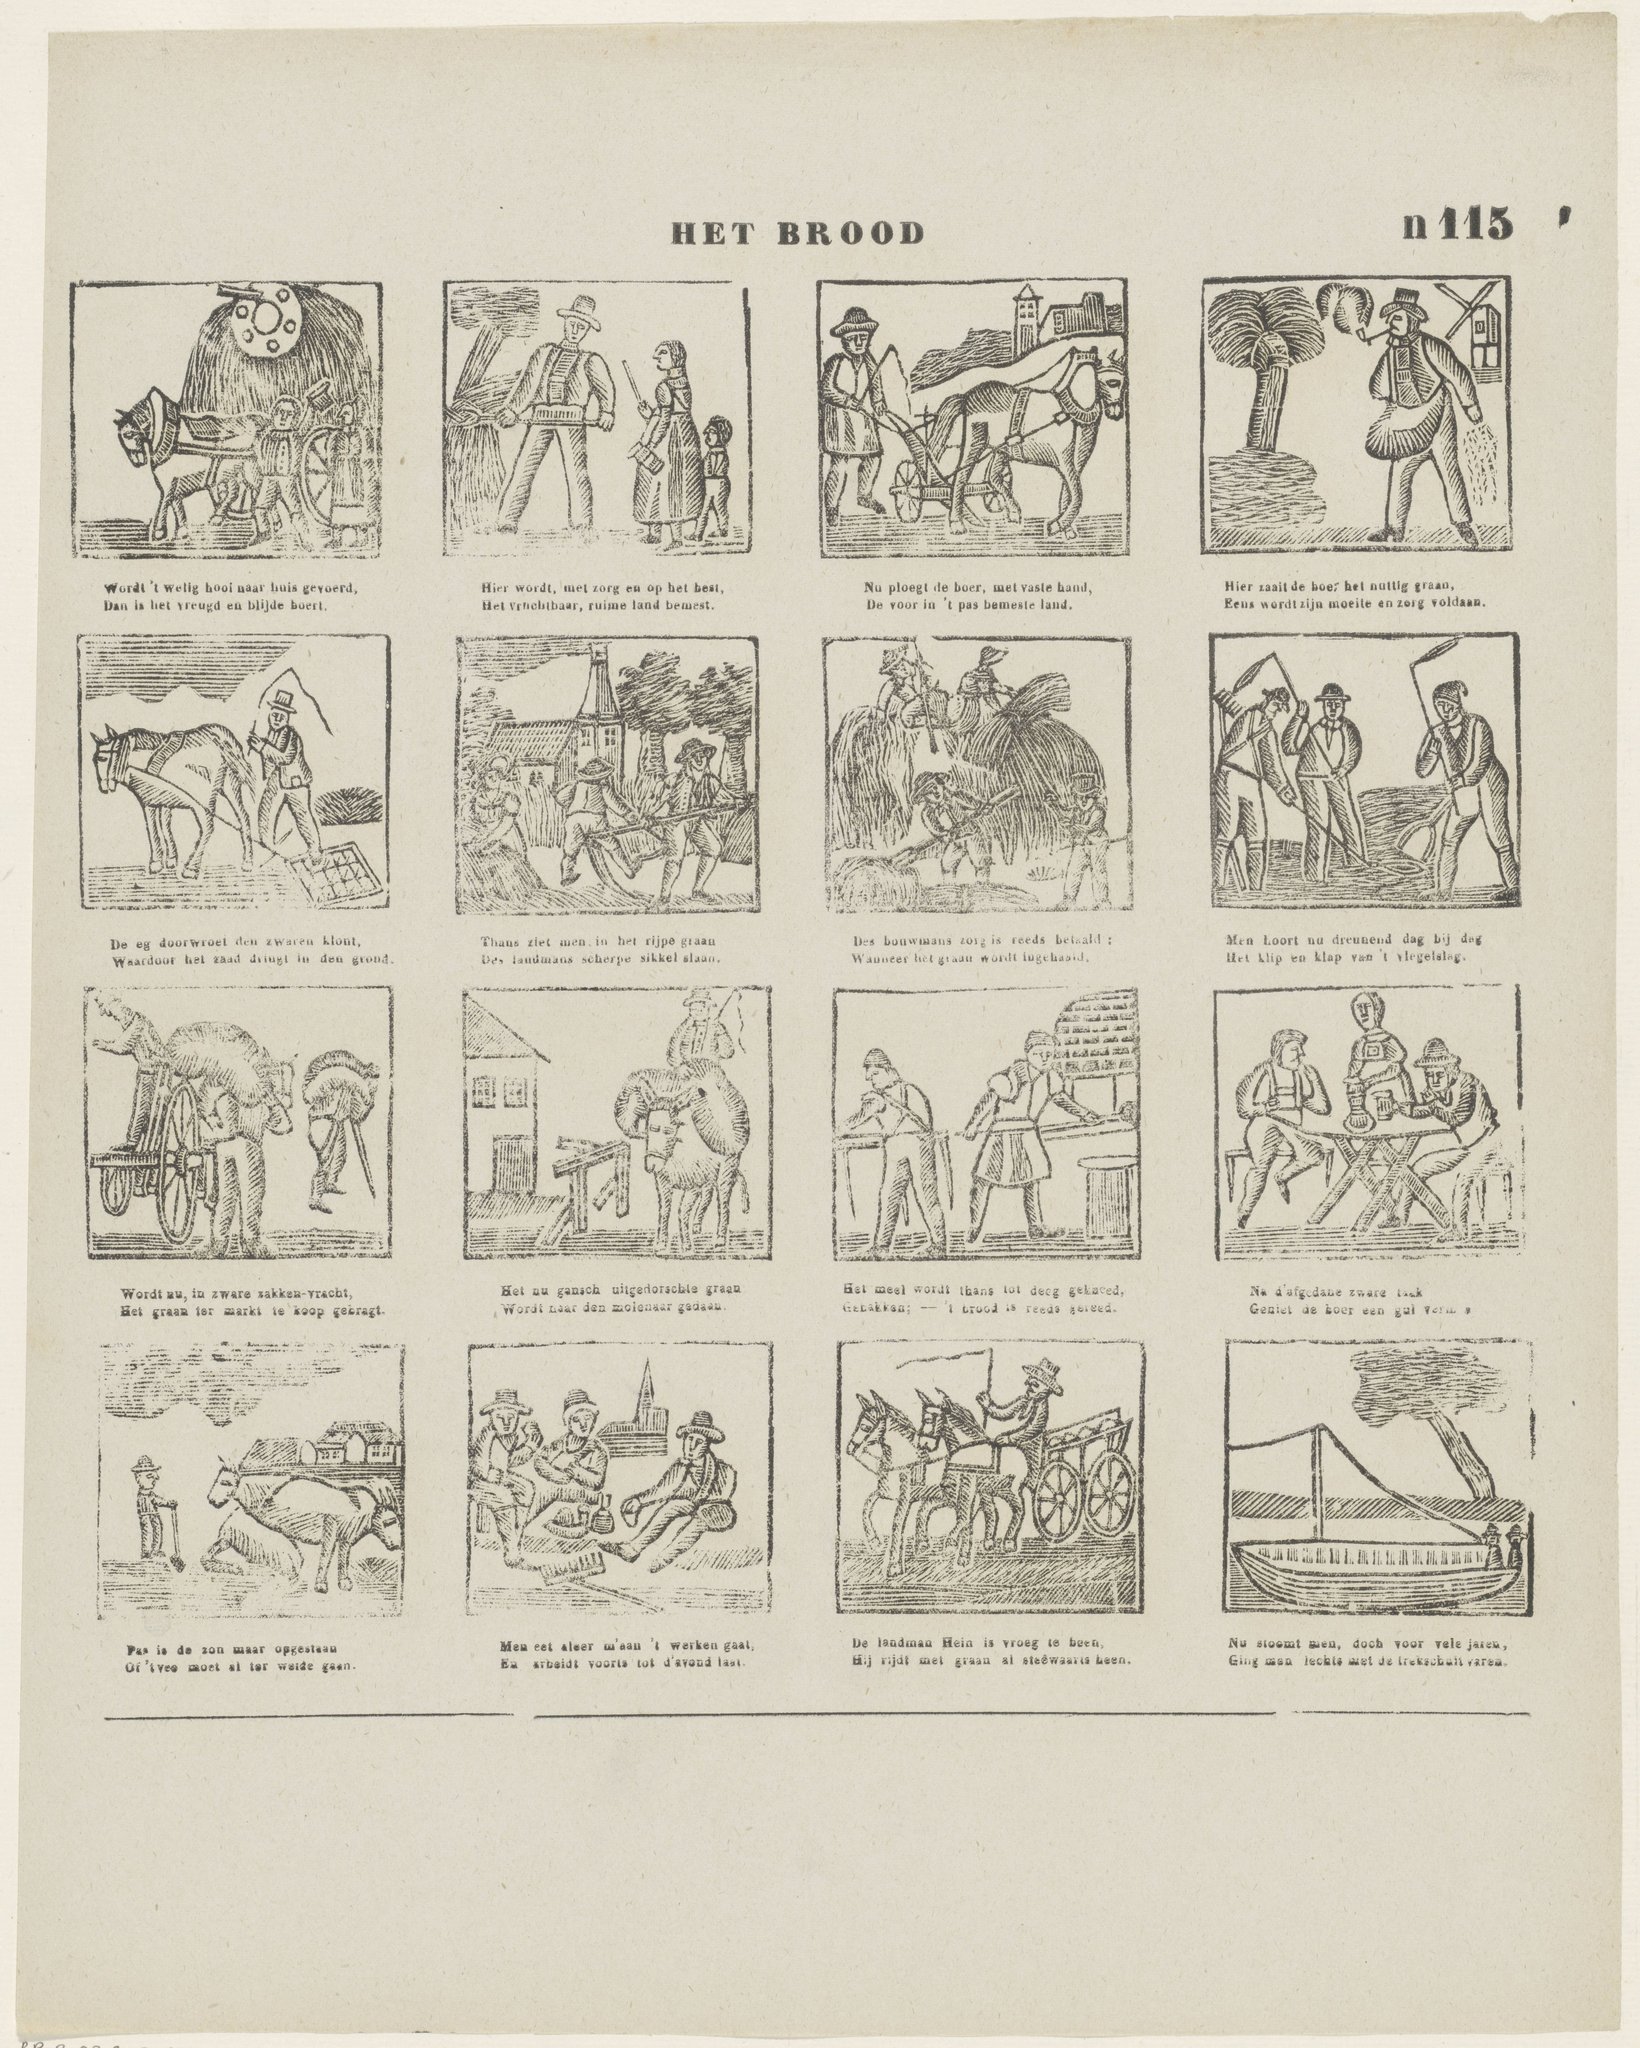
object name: popular print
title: Het brood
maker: Anonymous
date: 1856-1900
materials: paper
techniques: letterpress printing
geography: turnhout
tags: cereal, grain, corn (grass with grains, grown for food, e.g.: wheat, rice, rye, oats, maize, buckwheat, millet), agriculture, hay-wagon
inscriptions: collector's mark: Lugt 2760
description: Blad met 16 voorstellingen van landbouwtaferelen rondom de productie van brood. Onder elke voorstelling een tweeregelig vers. Genummerd rechtsboven: n 115.